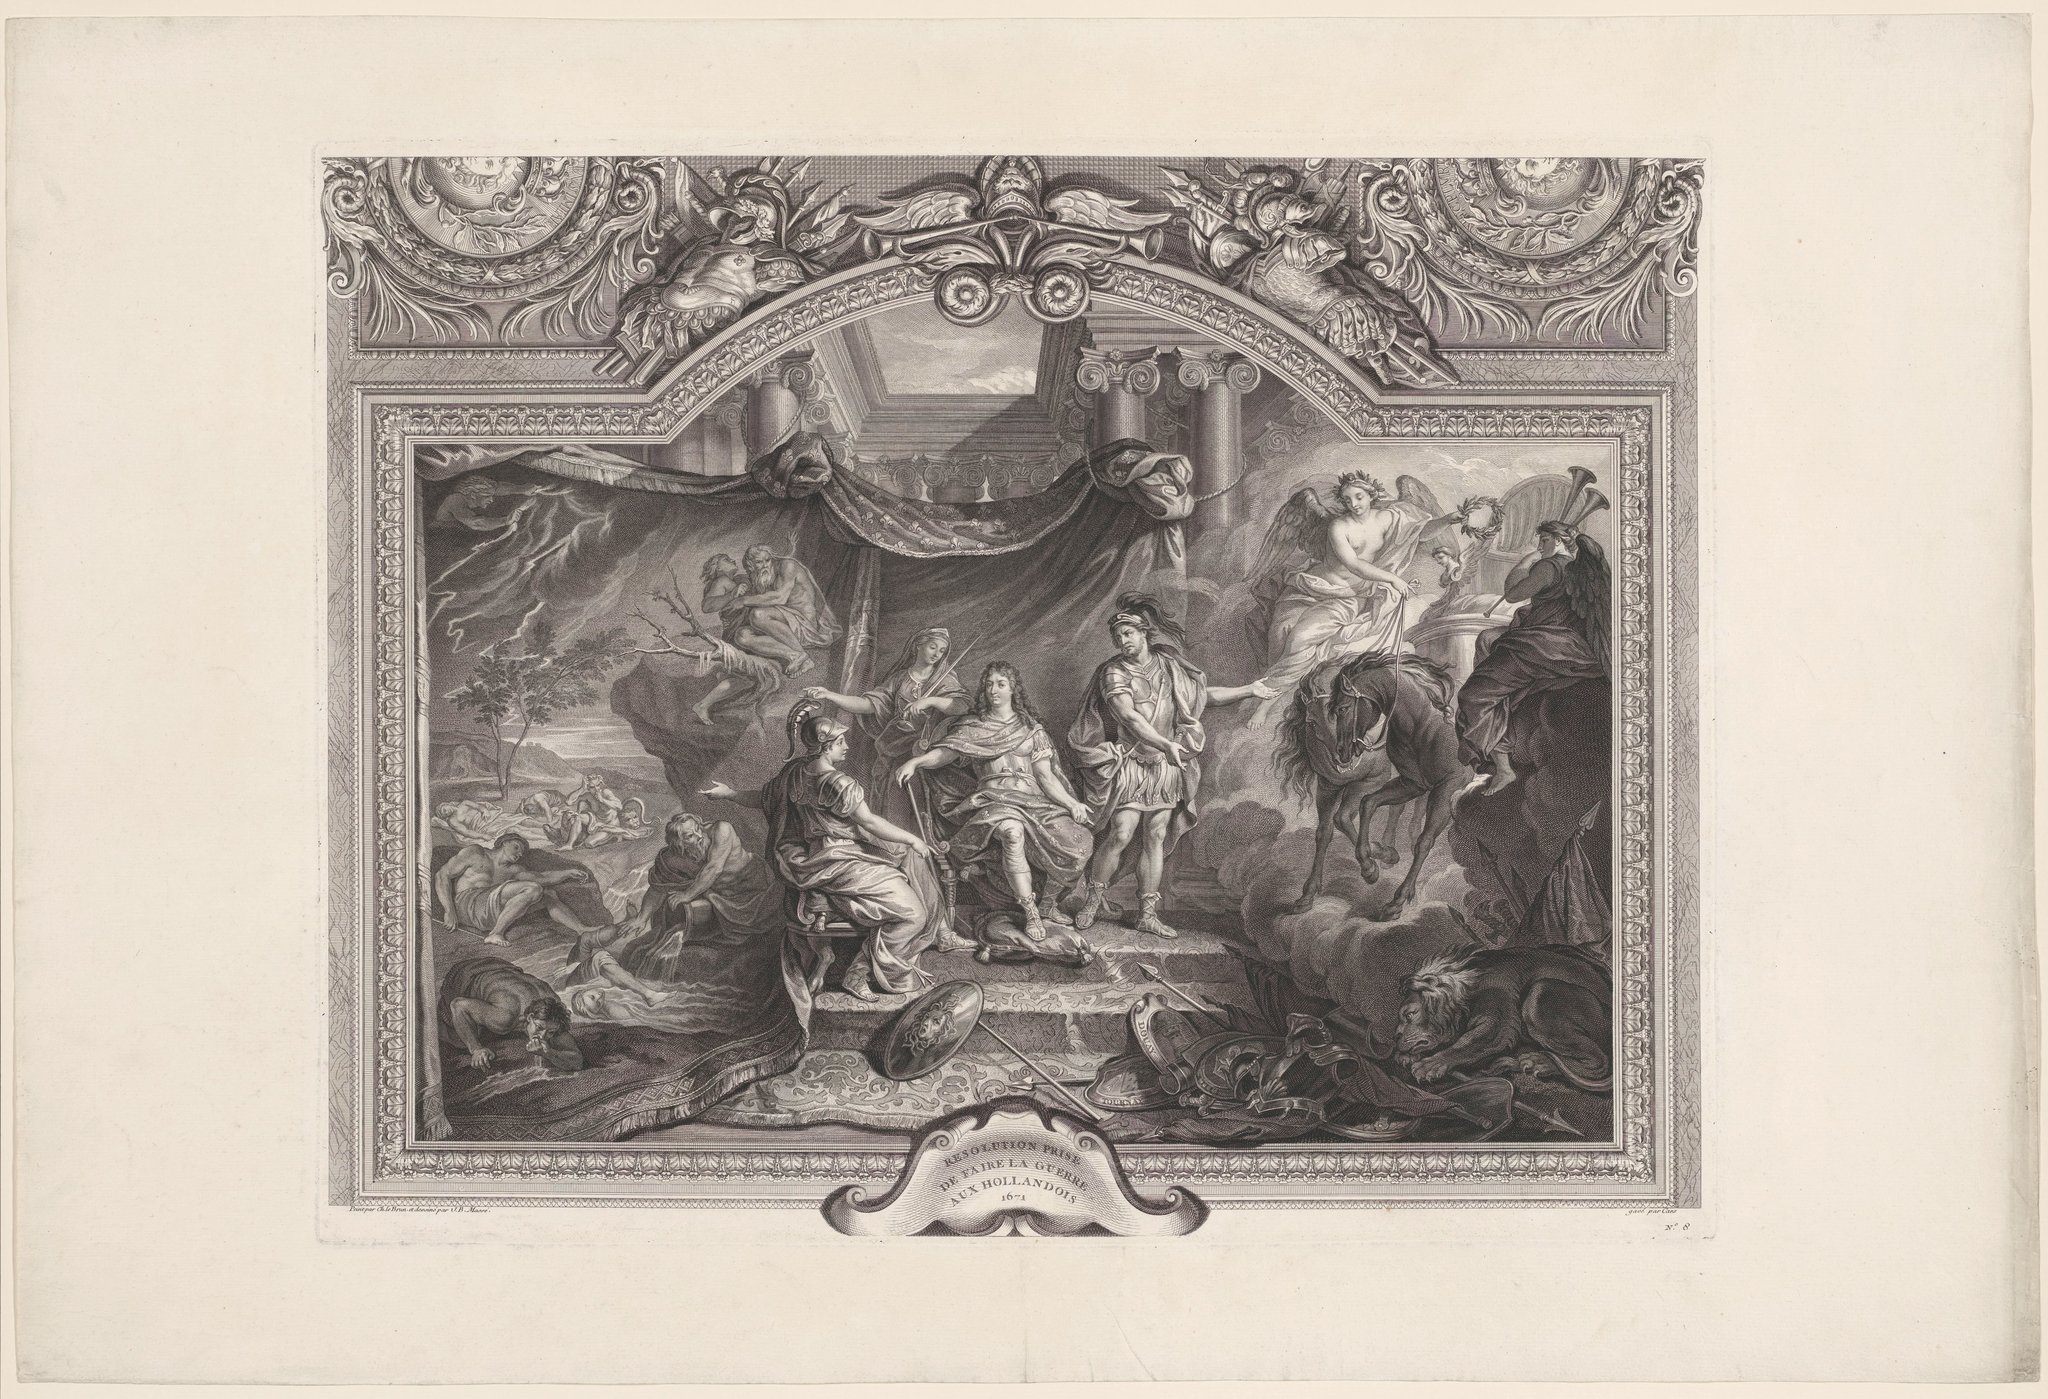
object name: print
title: Resolution prise de faire la guerre aux Hollandois, 1671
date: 1752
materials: paper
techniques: engraving, etching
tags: lodewijk xiv (koning van frankrijk), (story of) mars (ares), (story of) minerva (pallas, athena), historical persons, war, (decorated) ceiling, king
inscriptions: collector's mark: Lugt 2228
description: Prent gebruikt in: La Grande Galerie de Versailles, et les deux salons qui l'accompagnent, (...). Parijs: Imprimerie Royale, 1752.